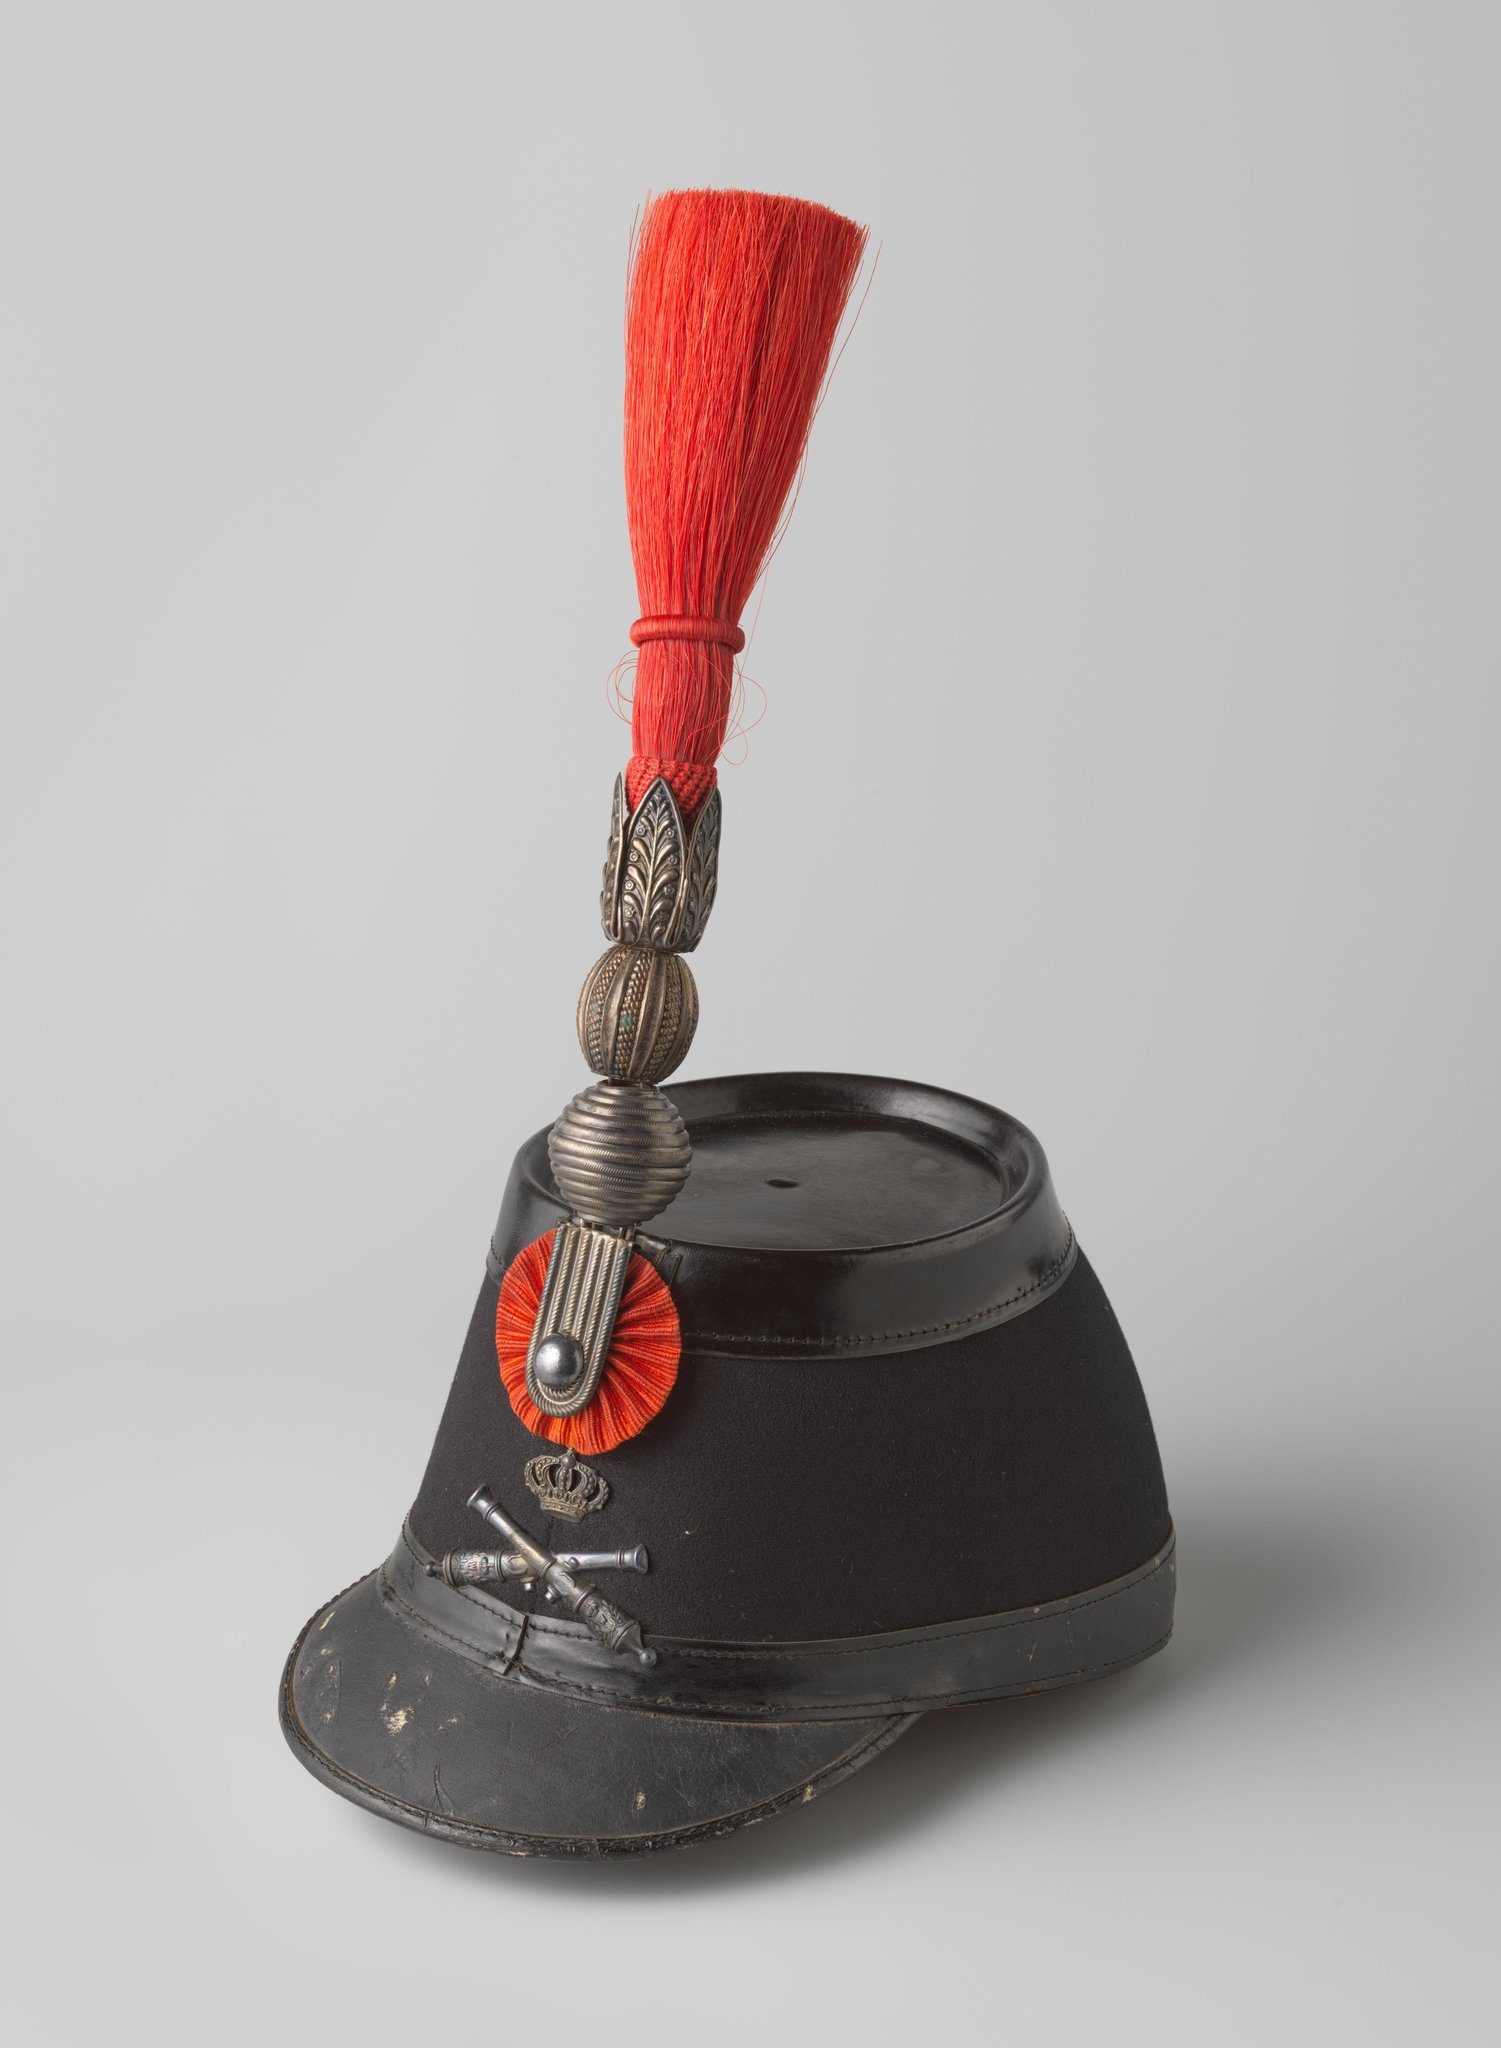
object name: menswear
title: Scheerkwastvormige rode losse pluim of vlam in een rode dop van koord, met lange dubbele draadsteel gestoken in pluimhouder, bestaande uit vijfbladige kelk en een bol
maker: Anonymous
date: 1870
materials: hair, metal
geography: paris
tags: amsterdam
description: Scheerkwastvormige rode losse pluim of vlam in een rode dop van koord, met lange dubbele draadsteel gestoken in pluimhouder, bestaande uit vijfbladige kelk en een bol. Van een luitenant van de Amsterdamse artillerie-schutterij. Adres: Manufacture/de Paris (op bodem van de sjako).